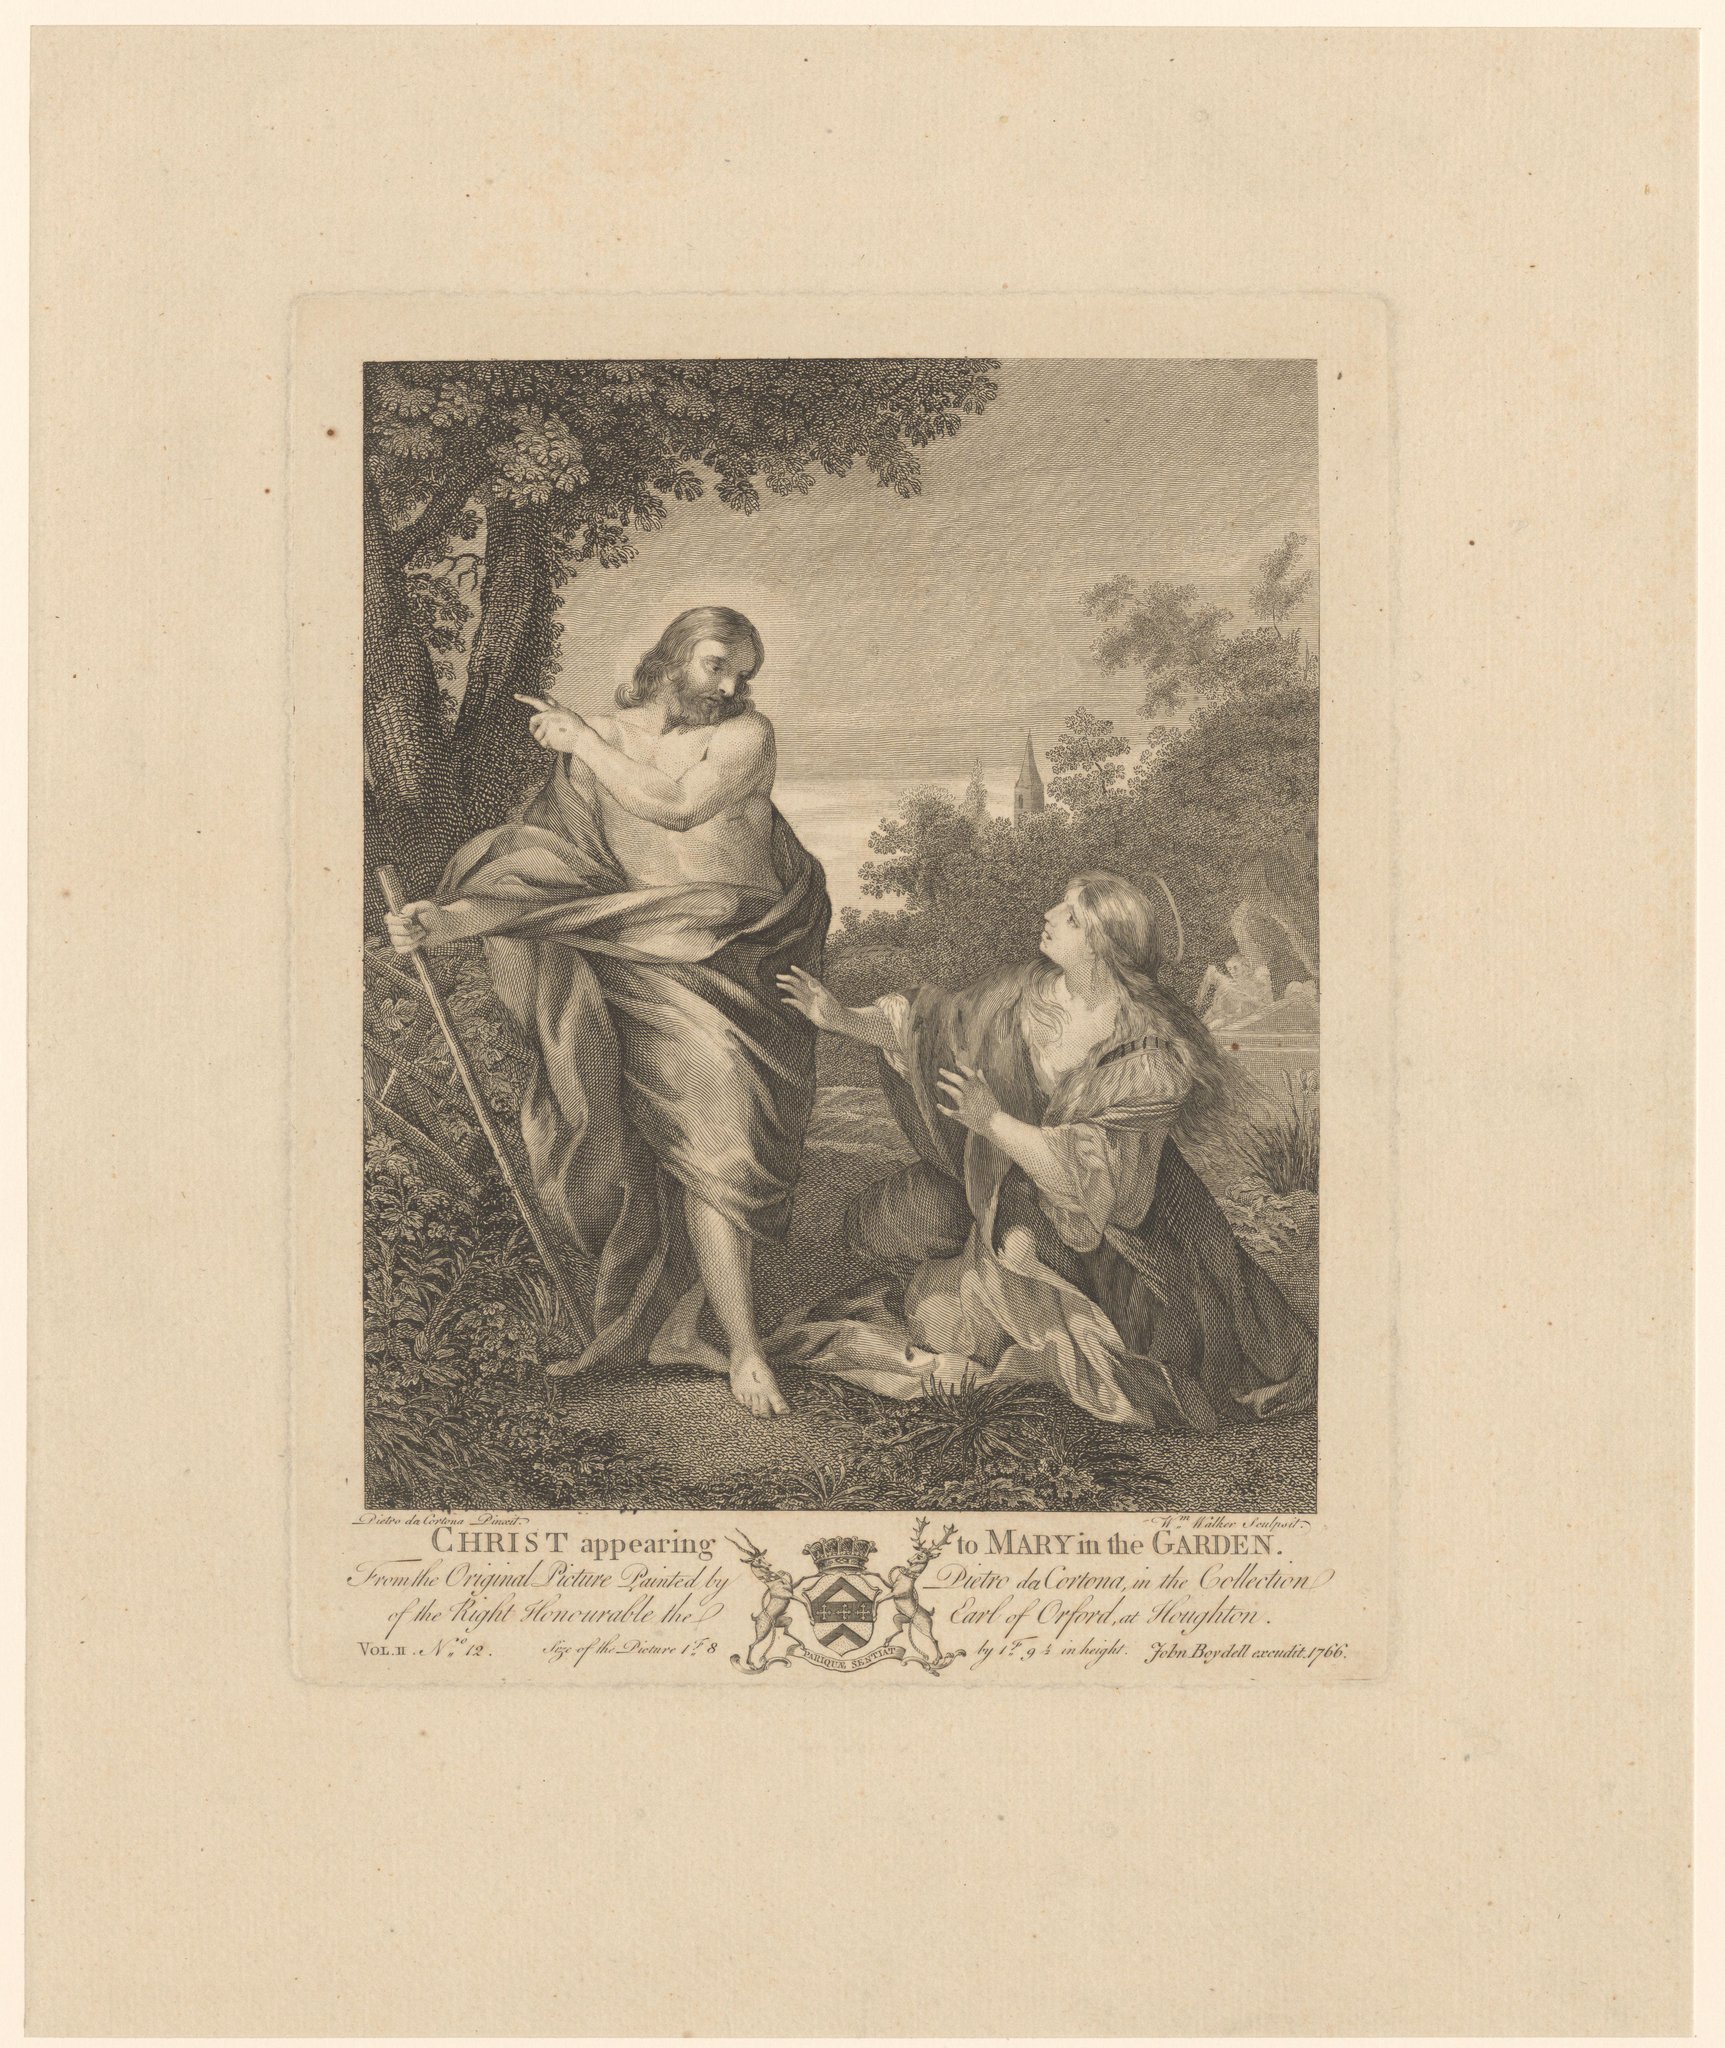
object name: print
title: Christus verschijnt aan Maria Magdalena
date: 1766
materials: paper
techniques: engraving, etching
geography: london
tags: mary magdalene kneeling before christ, who is usually represented as a gardener with a hoe and/or a spade; 'noli me tangere'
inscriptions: collector's mark: Lugt 2228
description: Tekst in het Engels in de ondermarge. Genummerd: 12.